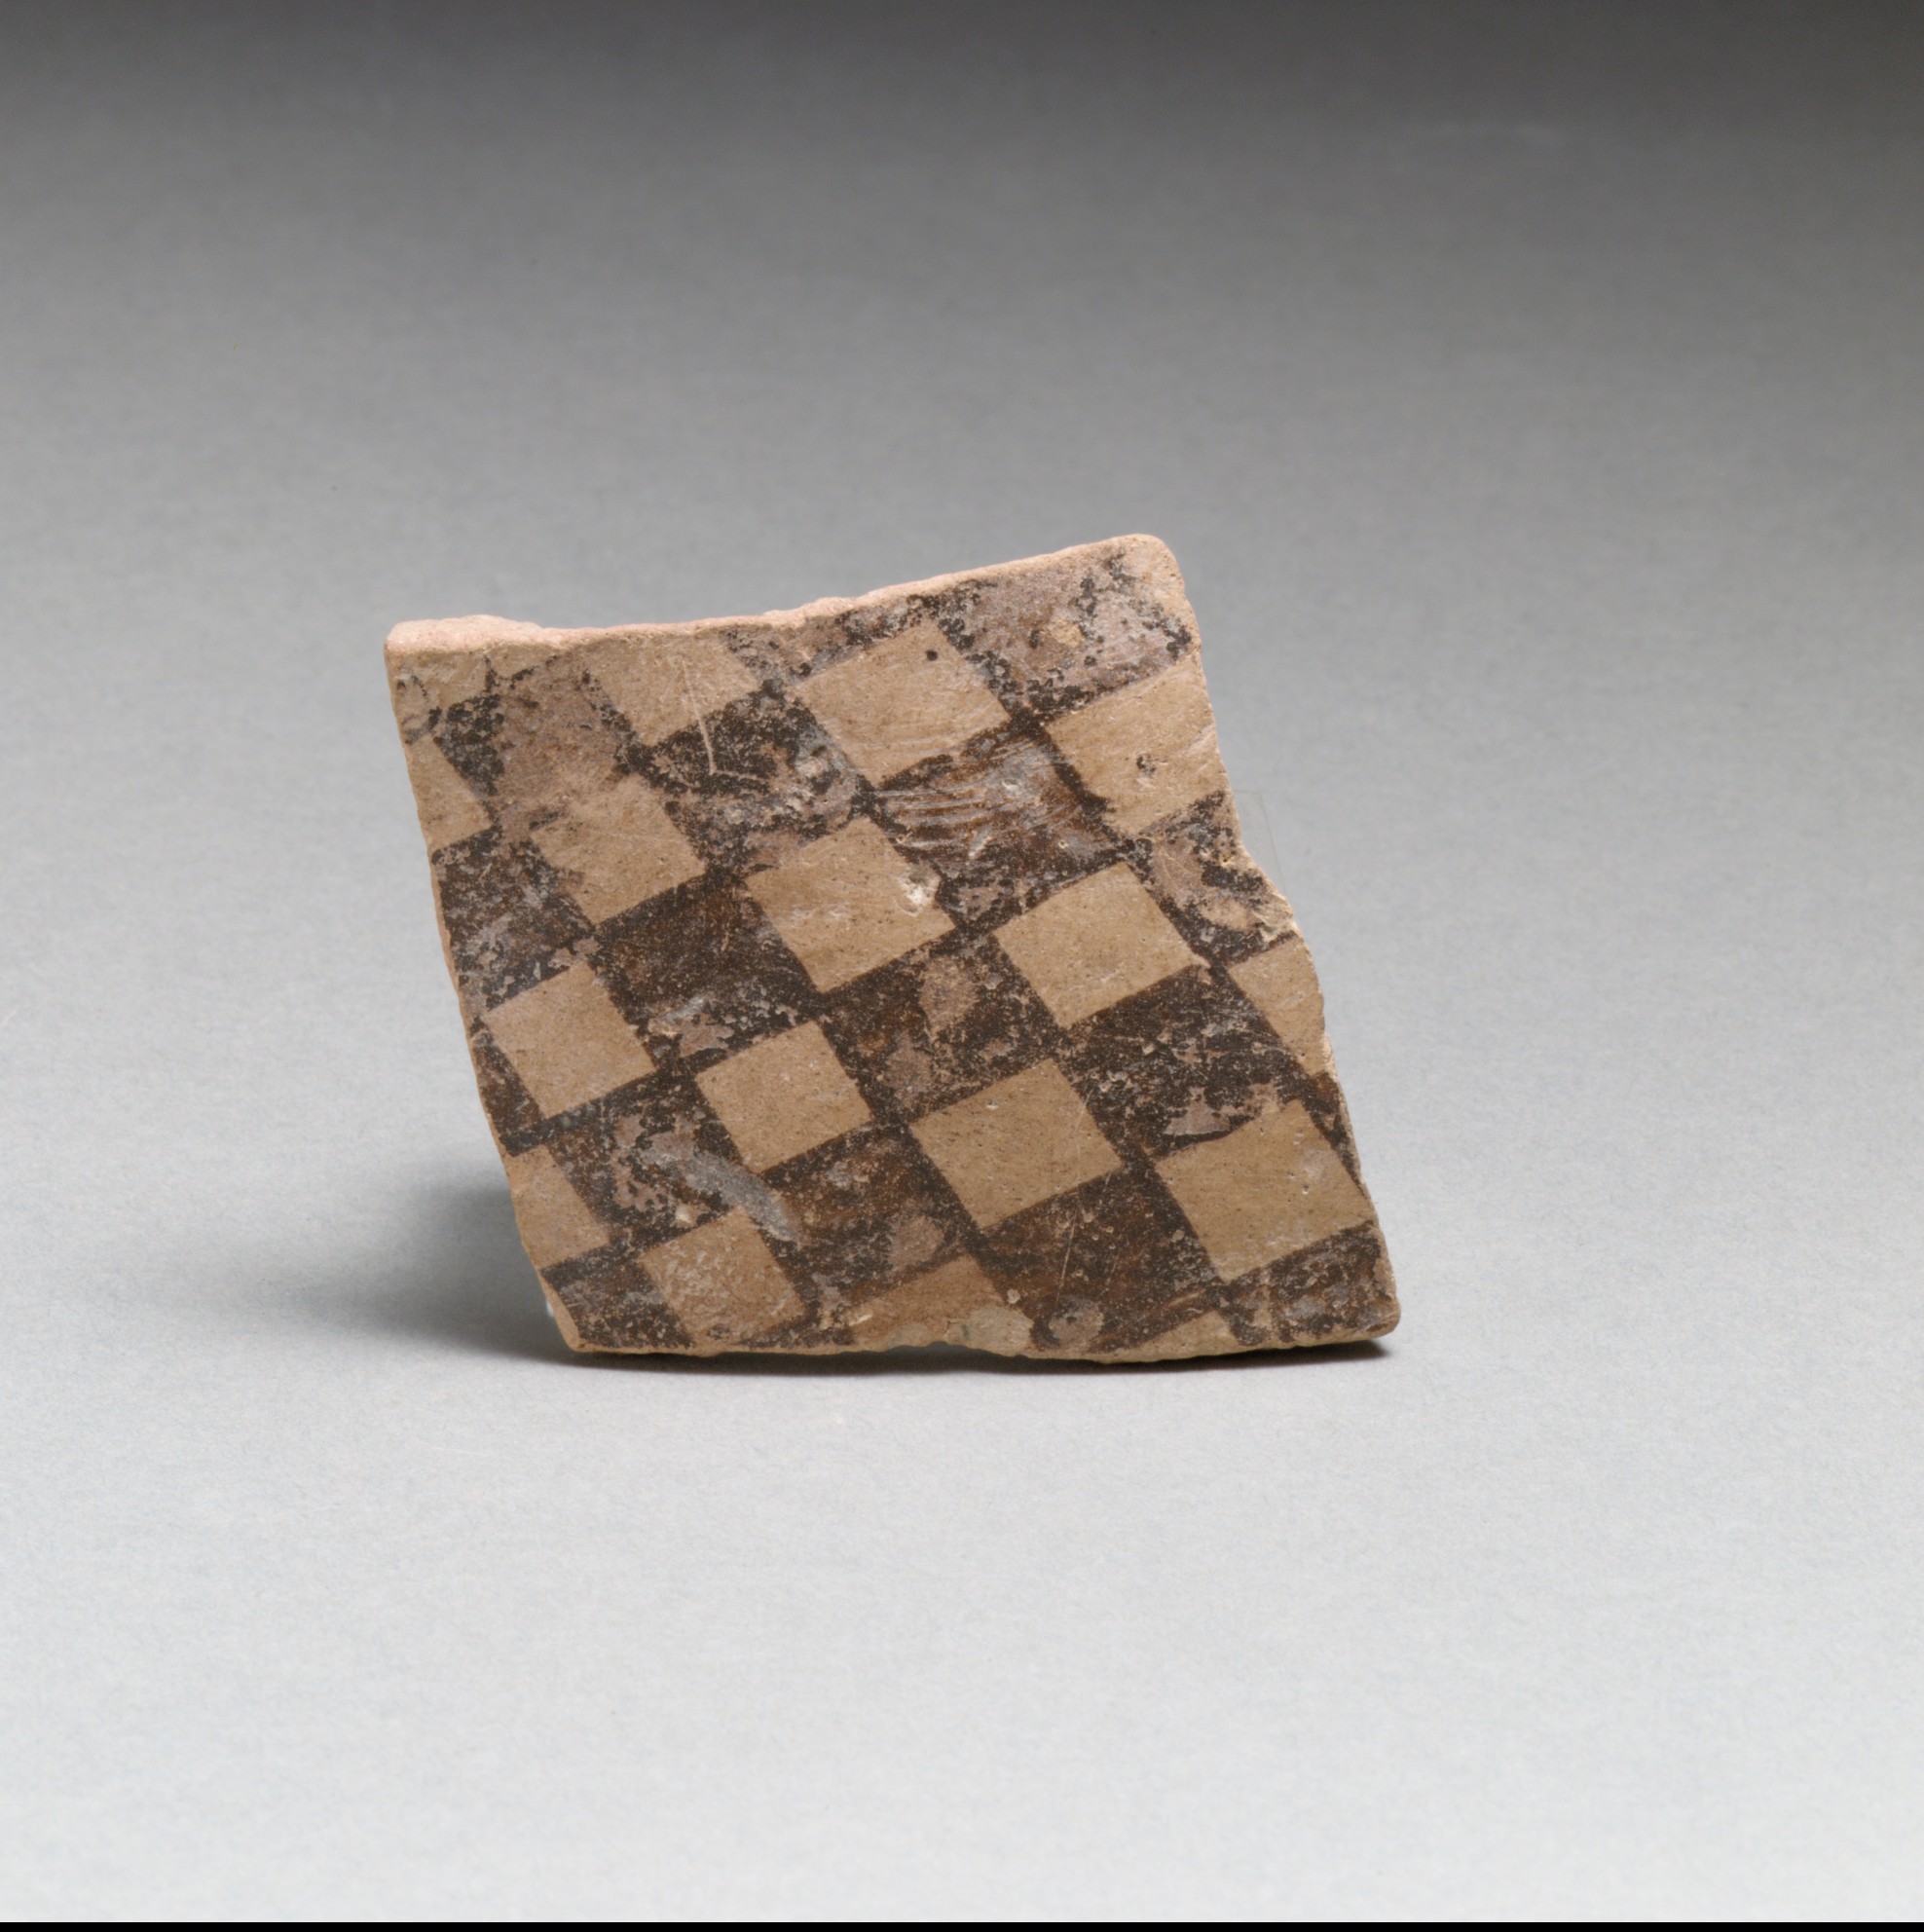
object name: vase fragment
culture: neolithic, thessaly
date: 4000-3000 BCE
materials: terracotta